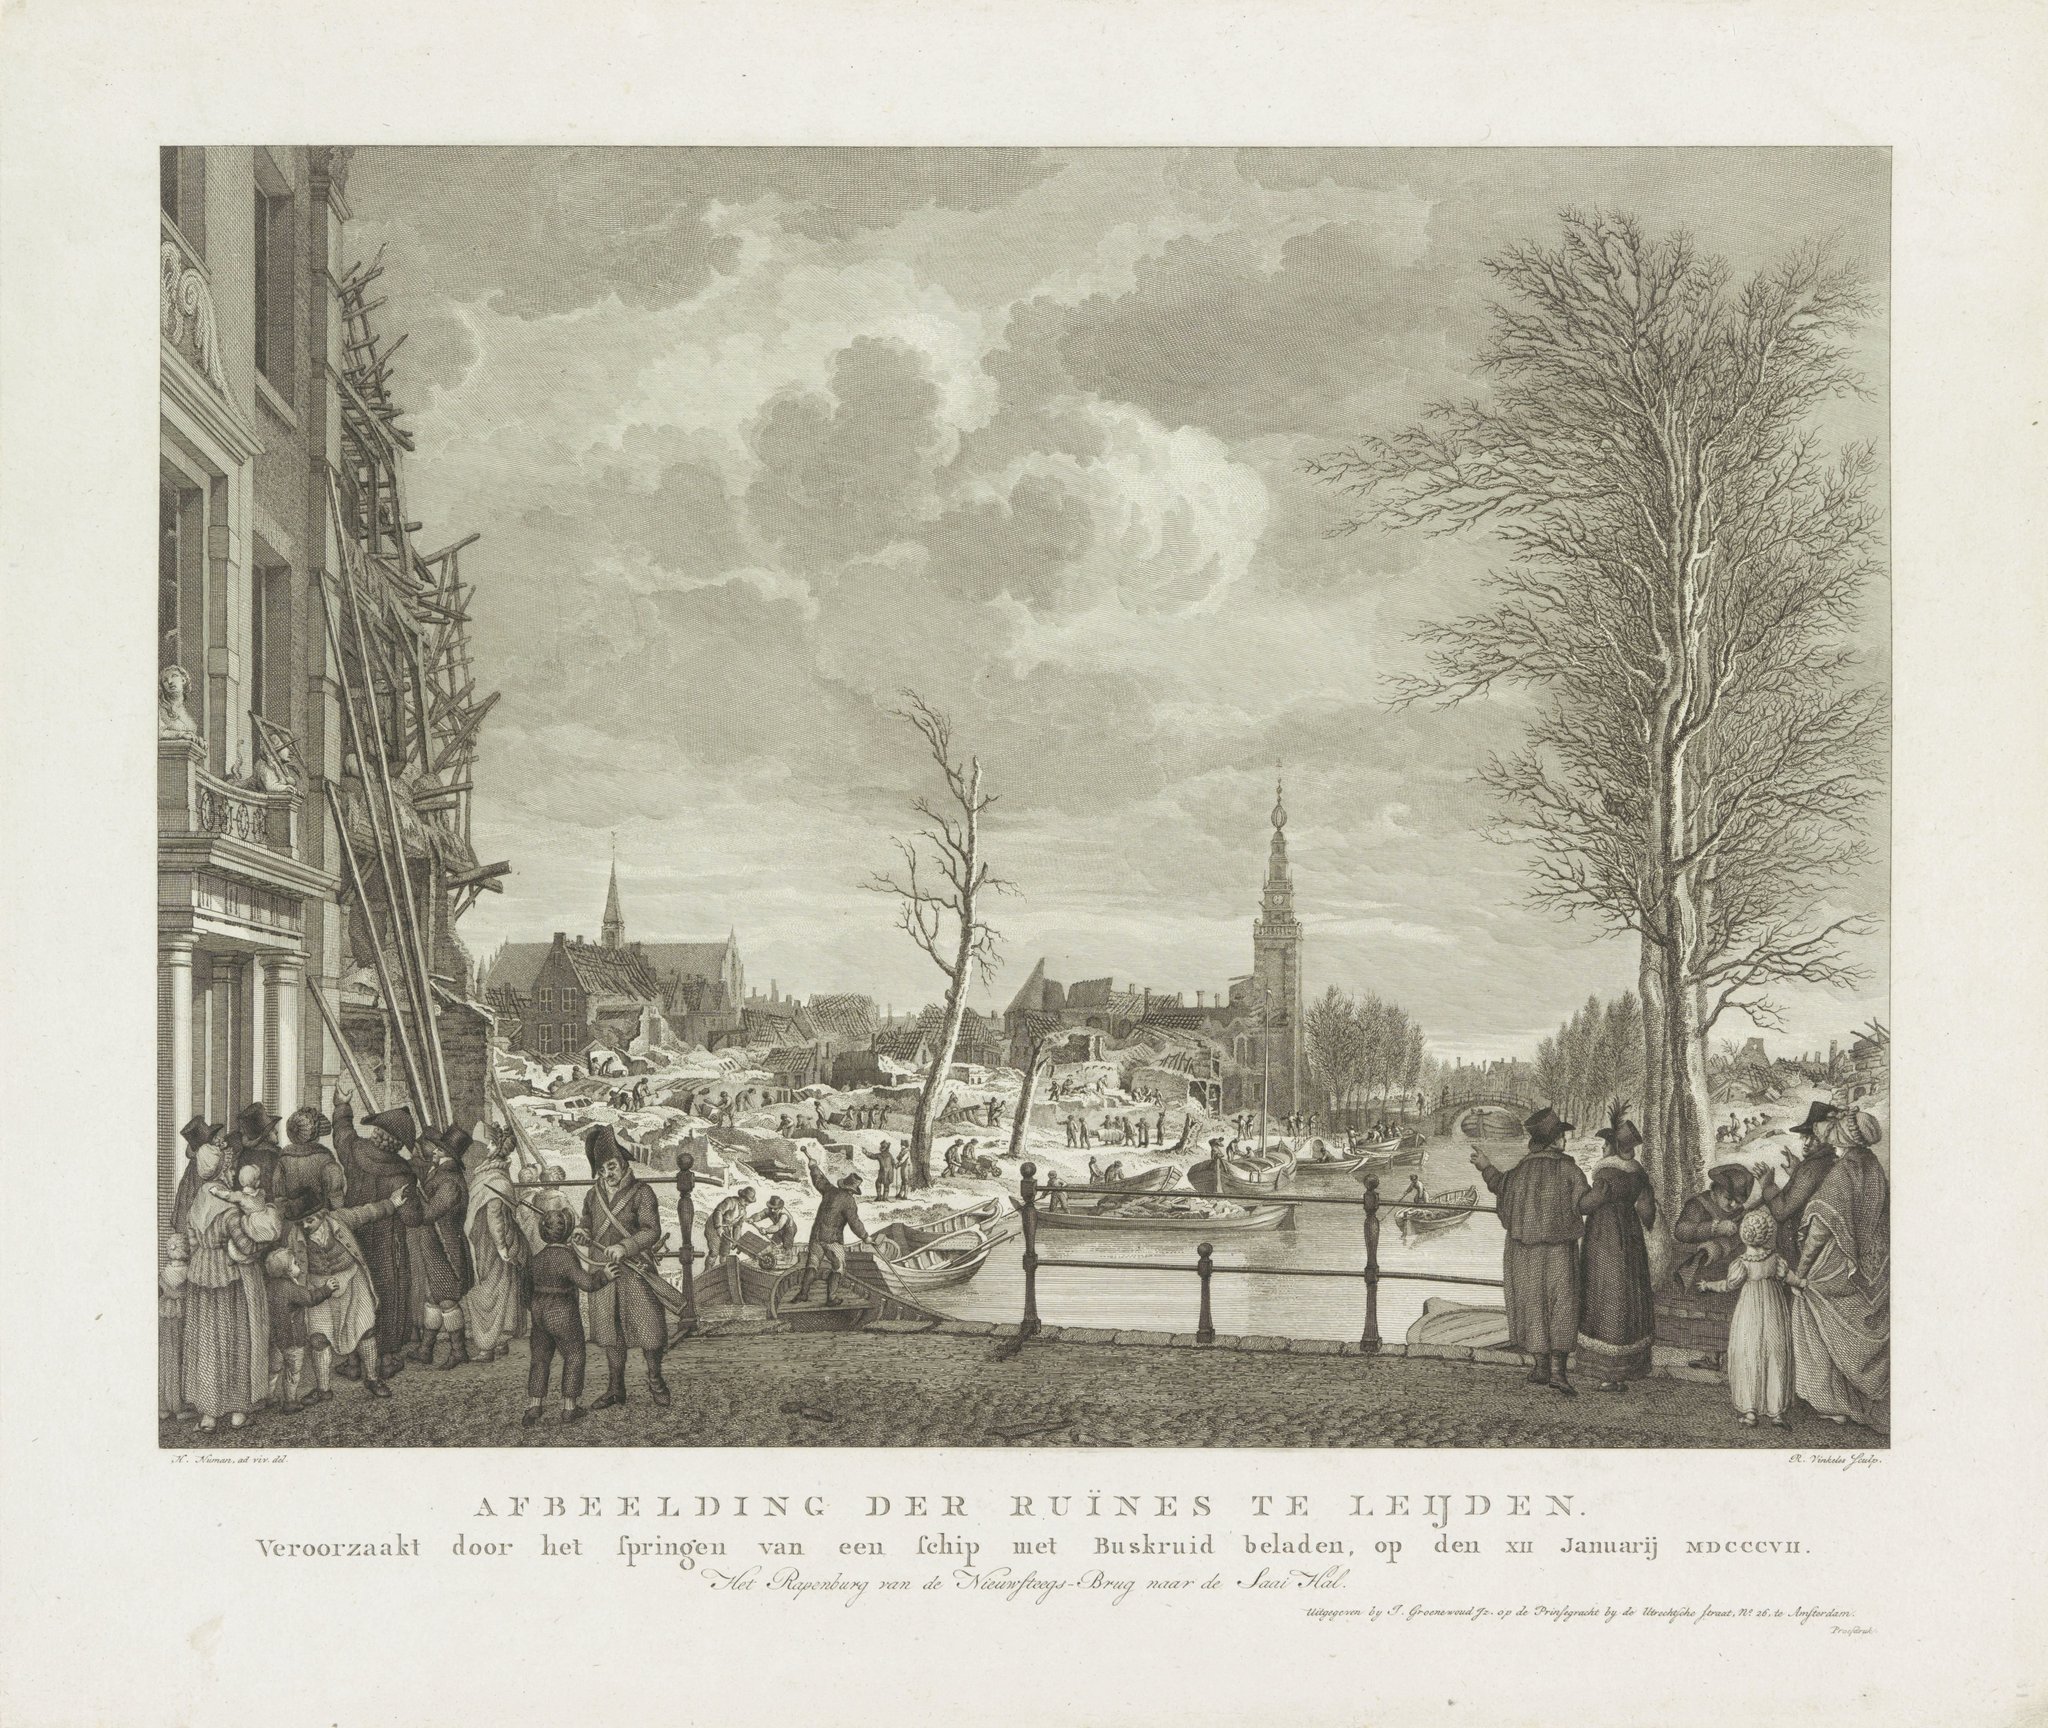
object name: print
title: Vier Kunstplaten voorstellende het Rapenburg binnen de stad Leyden, zoodanig als het (ter wederzijde) zich vertoond heeft, even vóór de noodlottige gebeurtenis, op den 12den Januarij 1807. als mede de wederzijdsche ruïnes door die ijselijke uitbarsting veroorzaakt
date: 1807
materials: paper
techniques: engraving, etching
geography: leiden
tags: gunpowder disaster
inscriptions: collector's mark: Lugt 2228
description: Gezicht vanaf de Nieuwsteegbrug op de herstelwerkzaamheden in het verwoeste gebied na de buskruitramp op het Steenschuur, een gracht in het verlengde van het Rapenburg, te Leiden op 12 januari 1807. Links op de voorgrond het huis van schepen J.W. van Noort, op de achtergrond in het midden de Saaihal. Zie ook de verklaring.